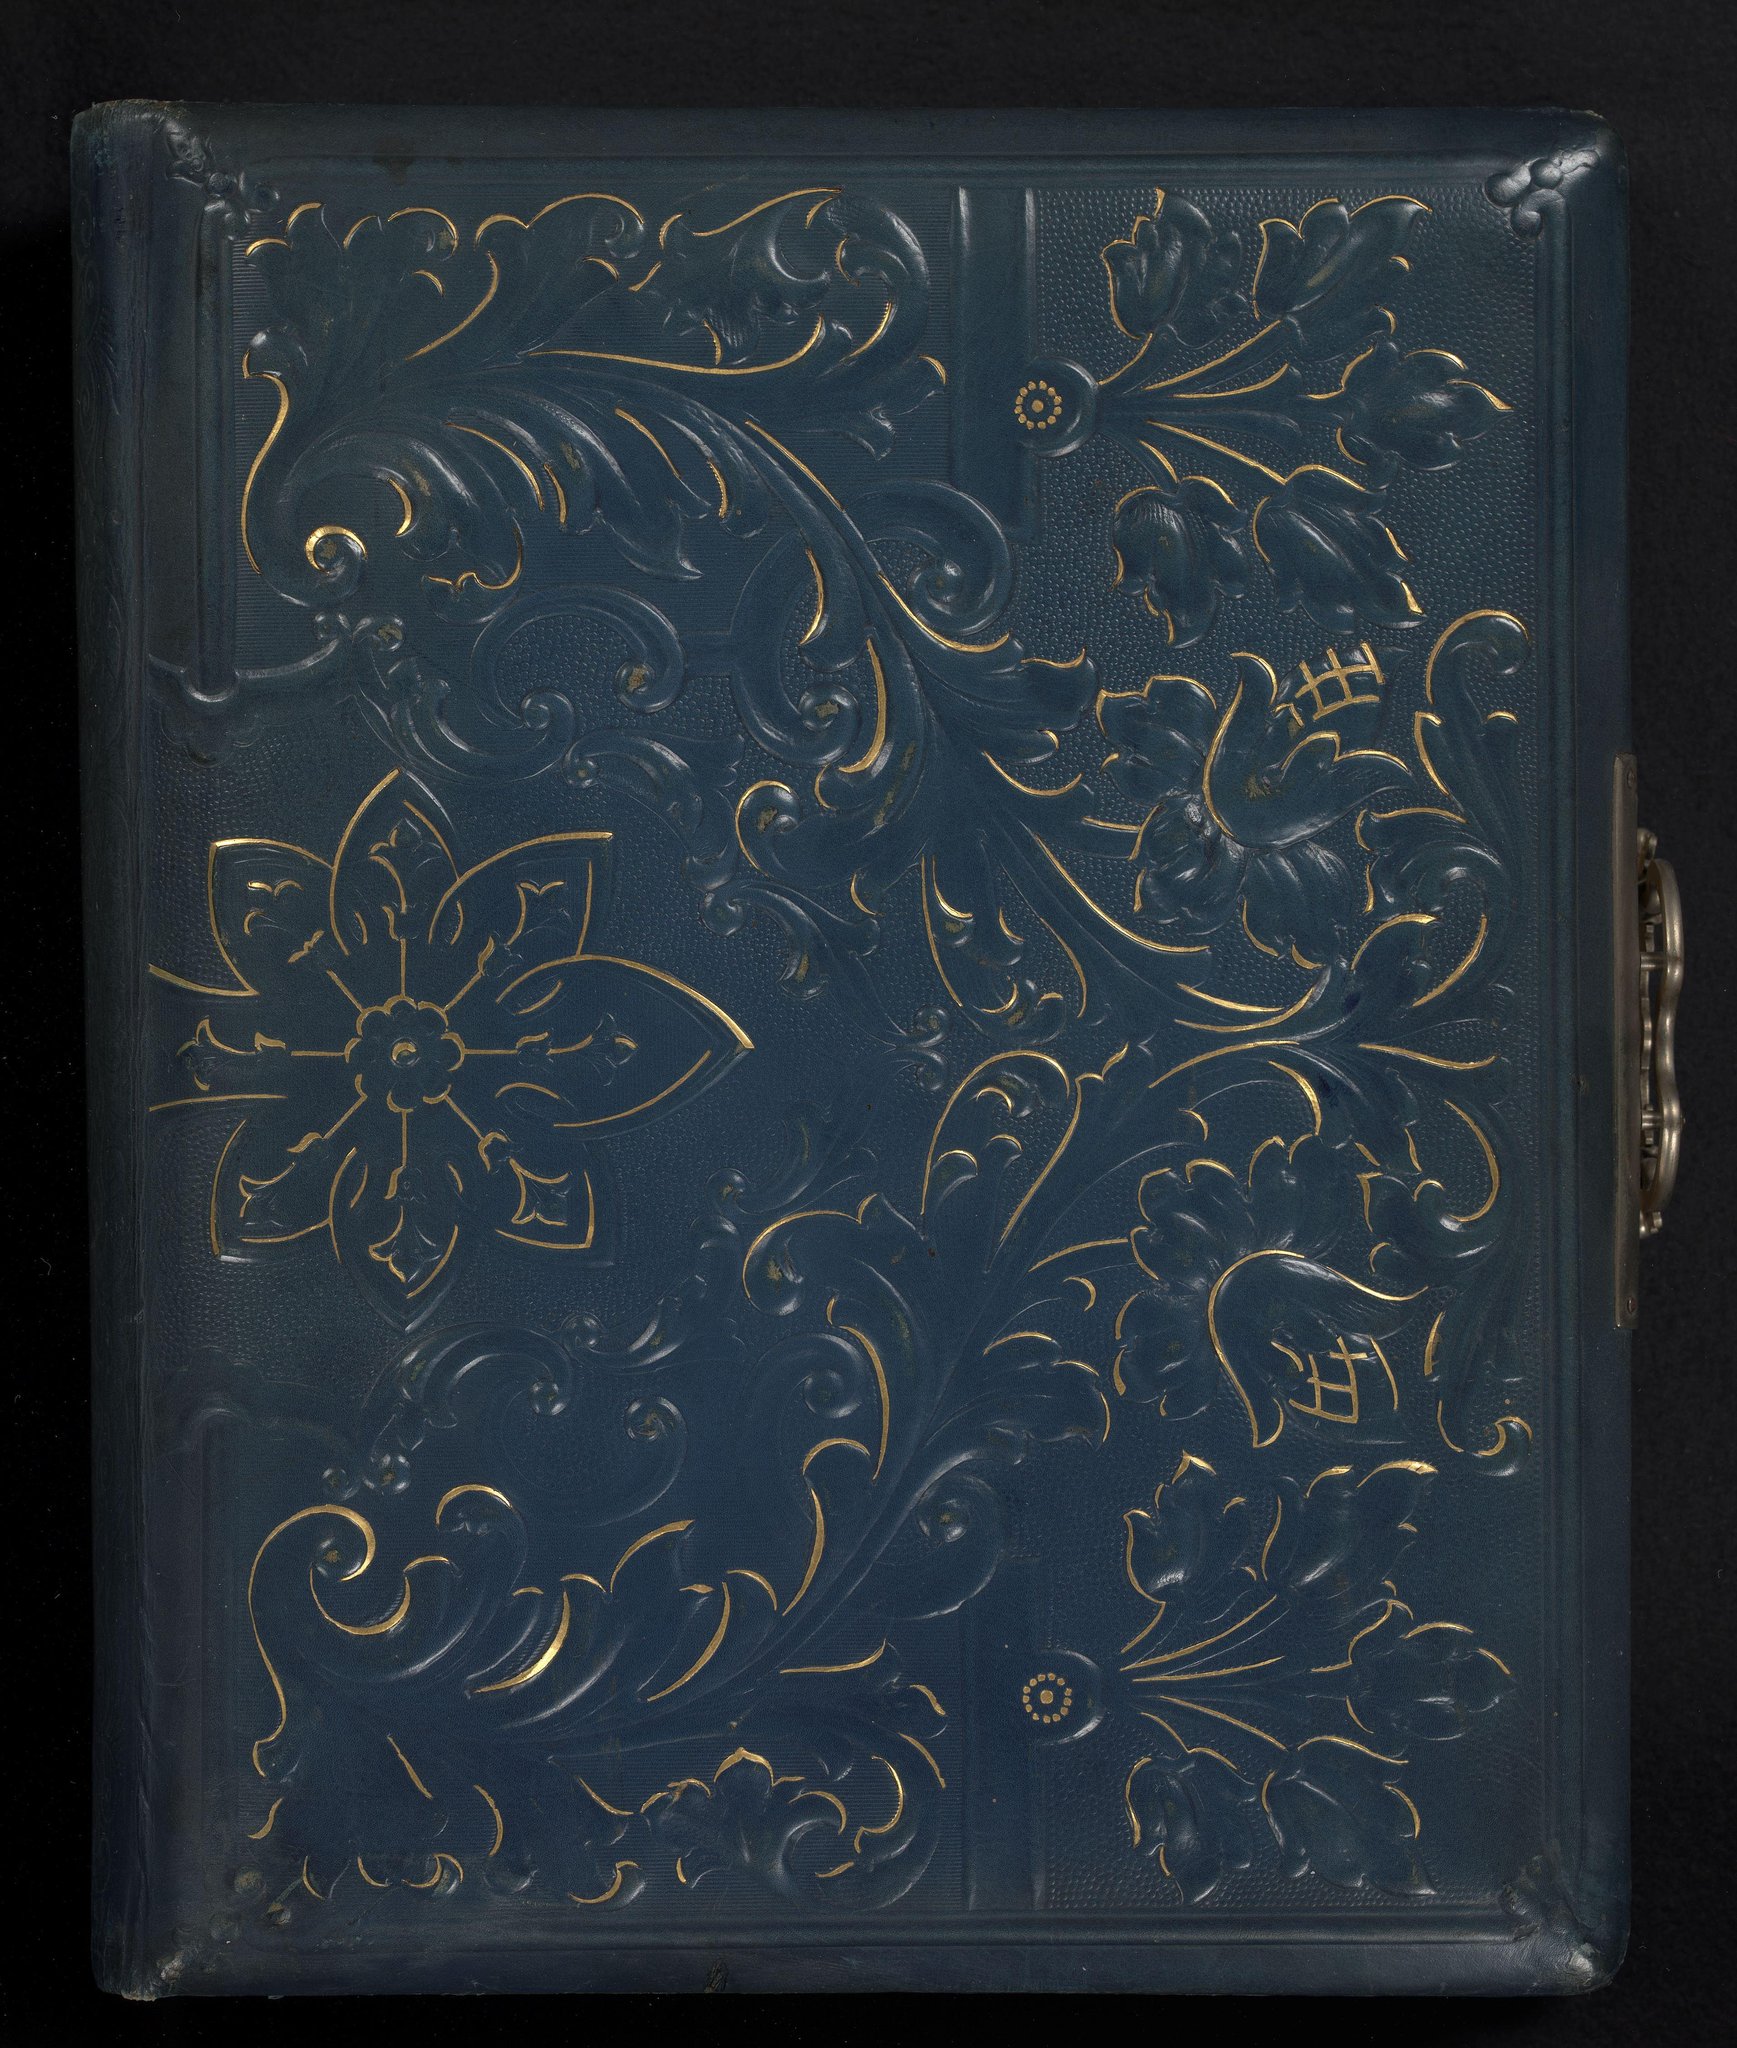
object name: photograph album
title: Nederlands fotoalbum met 18 foto's van acteurs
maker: Anonymous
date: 1880-1940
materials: cardboard, chromium, leather, paper, photographic support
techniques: albumen print, photograph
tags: berlin, paris, sculptor, sarah bernhardt, historical persons - bb - woman, historical persons, portrait of actor, actress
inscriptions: collector's mark: ‘Dienst Verspreide Rijkskollekties (...) A 668’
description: Fotoalbum met portretten van acteurs en theaterstukken. Het album bevat 16 bladen met insteek passe-partouts voor kabinetkaarten. In totaal bevat het album 18 foto's. Hiervan zitten 4 foto's los voorin het album. Ook is er variatie in zowel de gebruikte fotografische als fotomechanische technieken. Enkele bekende personen die zijn afgebeeld zijn: Ernst von Possart, Heinrich Vogl, Sarah Bernhardt en Erich Kleiber. Ook zitten er enkele verwijzingen in naar theaterstukken (acteurs afgebeeld in kostuum).